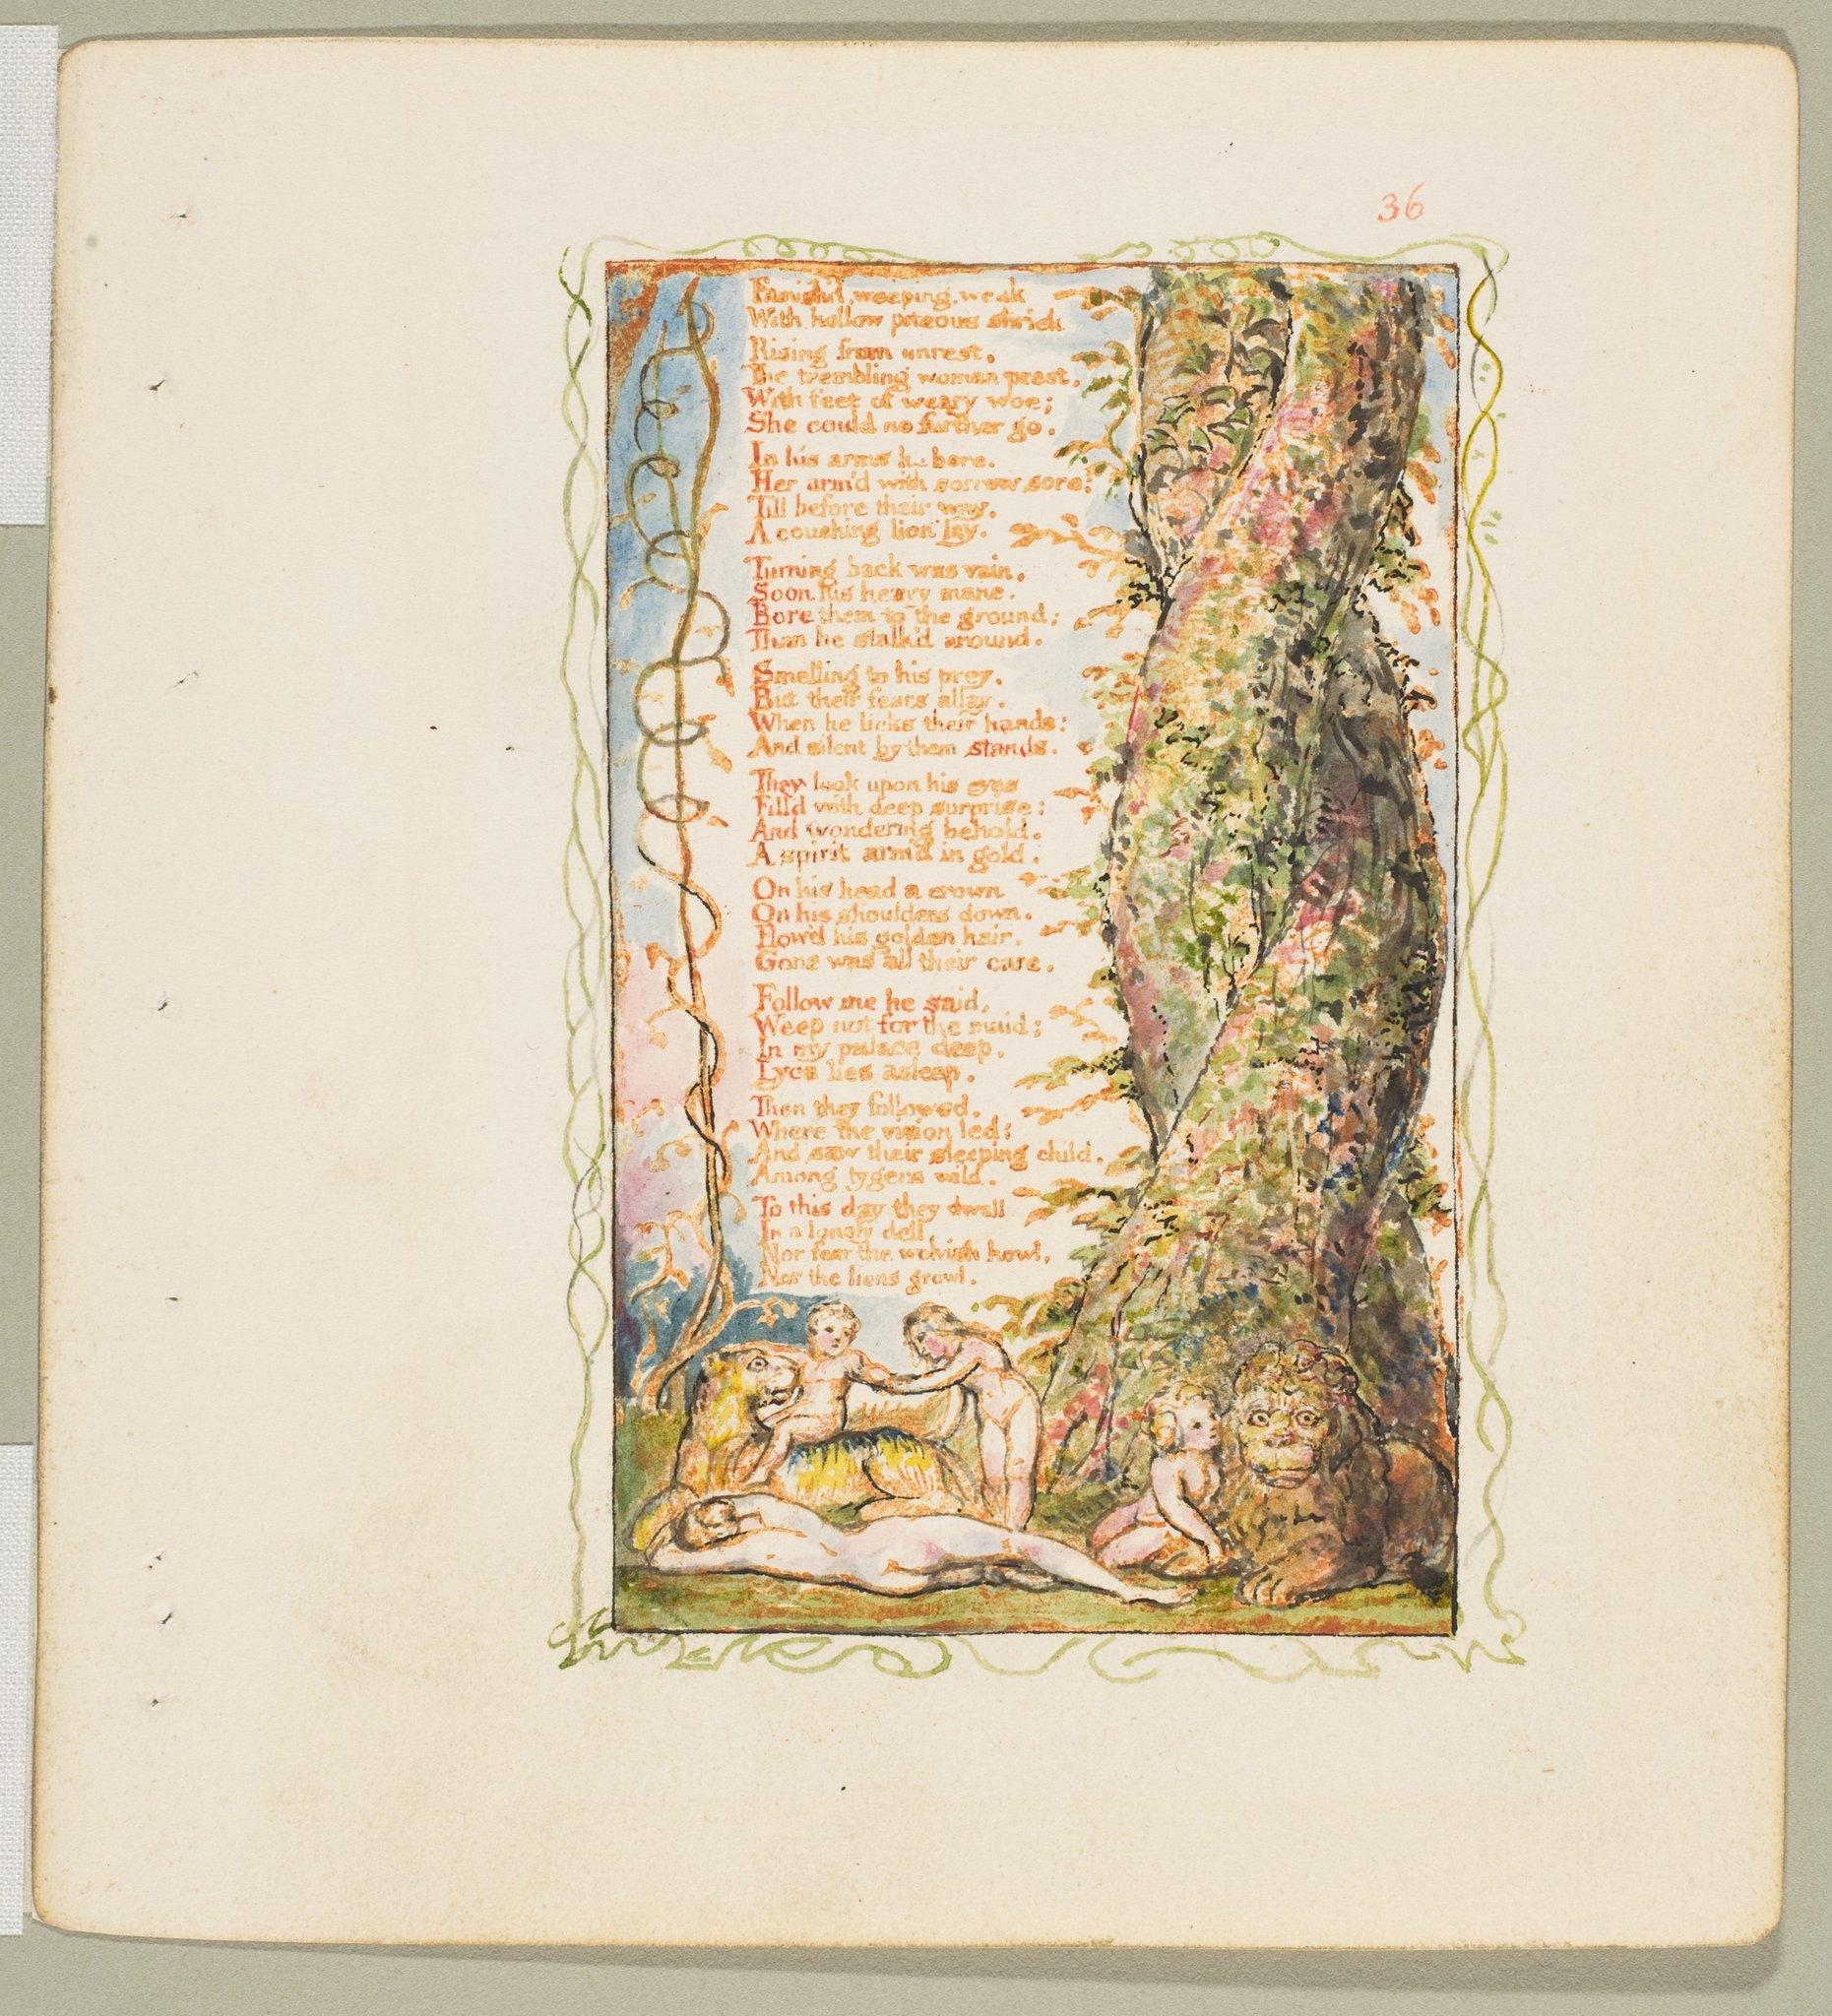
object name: print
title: Songs of Experience: The Little Girl Found (second plate)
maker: william blake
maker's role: artist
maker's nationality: british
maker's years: 1757-1827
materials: gold, ink, shell, watercolor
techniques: etching, hand coloring, printing, relief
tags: girls,female nudes,lions,trees